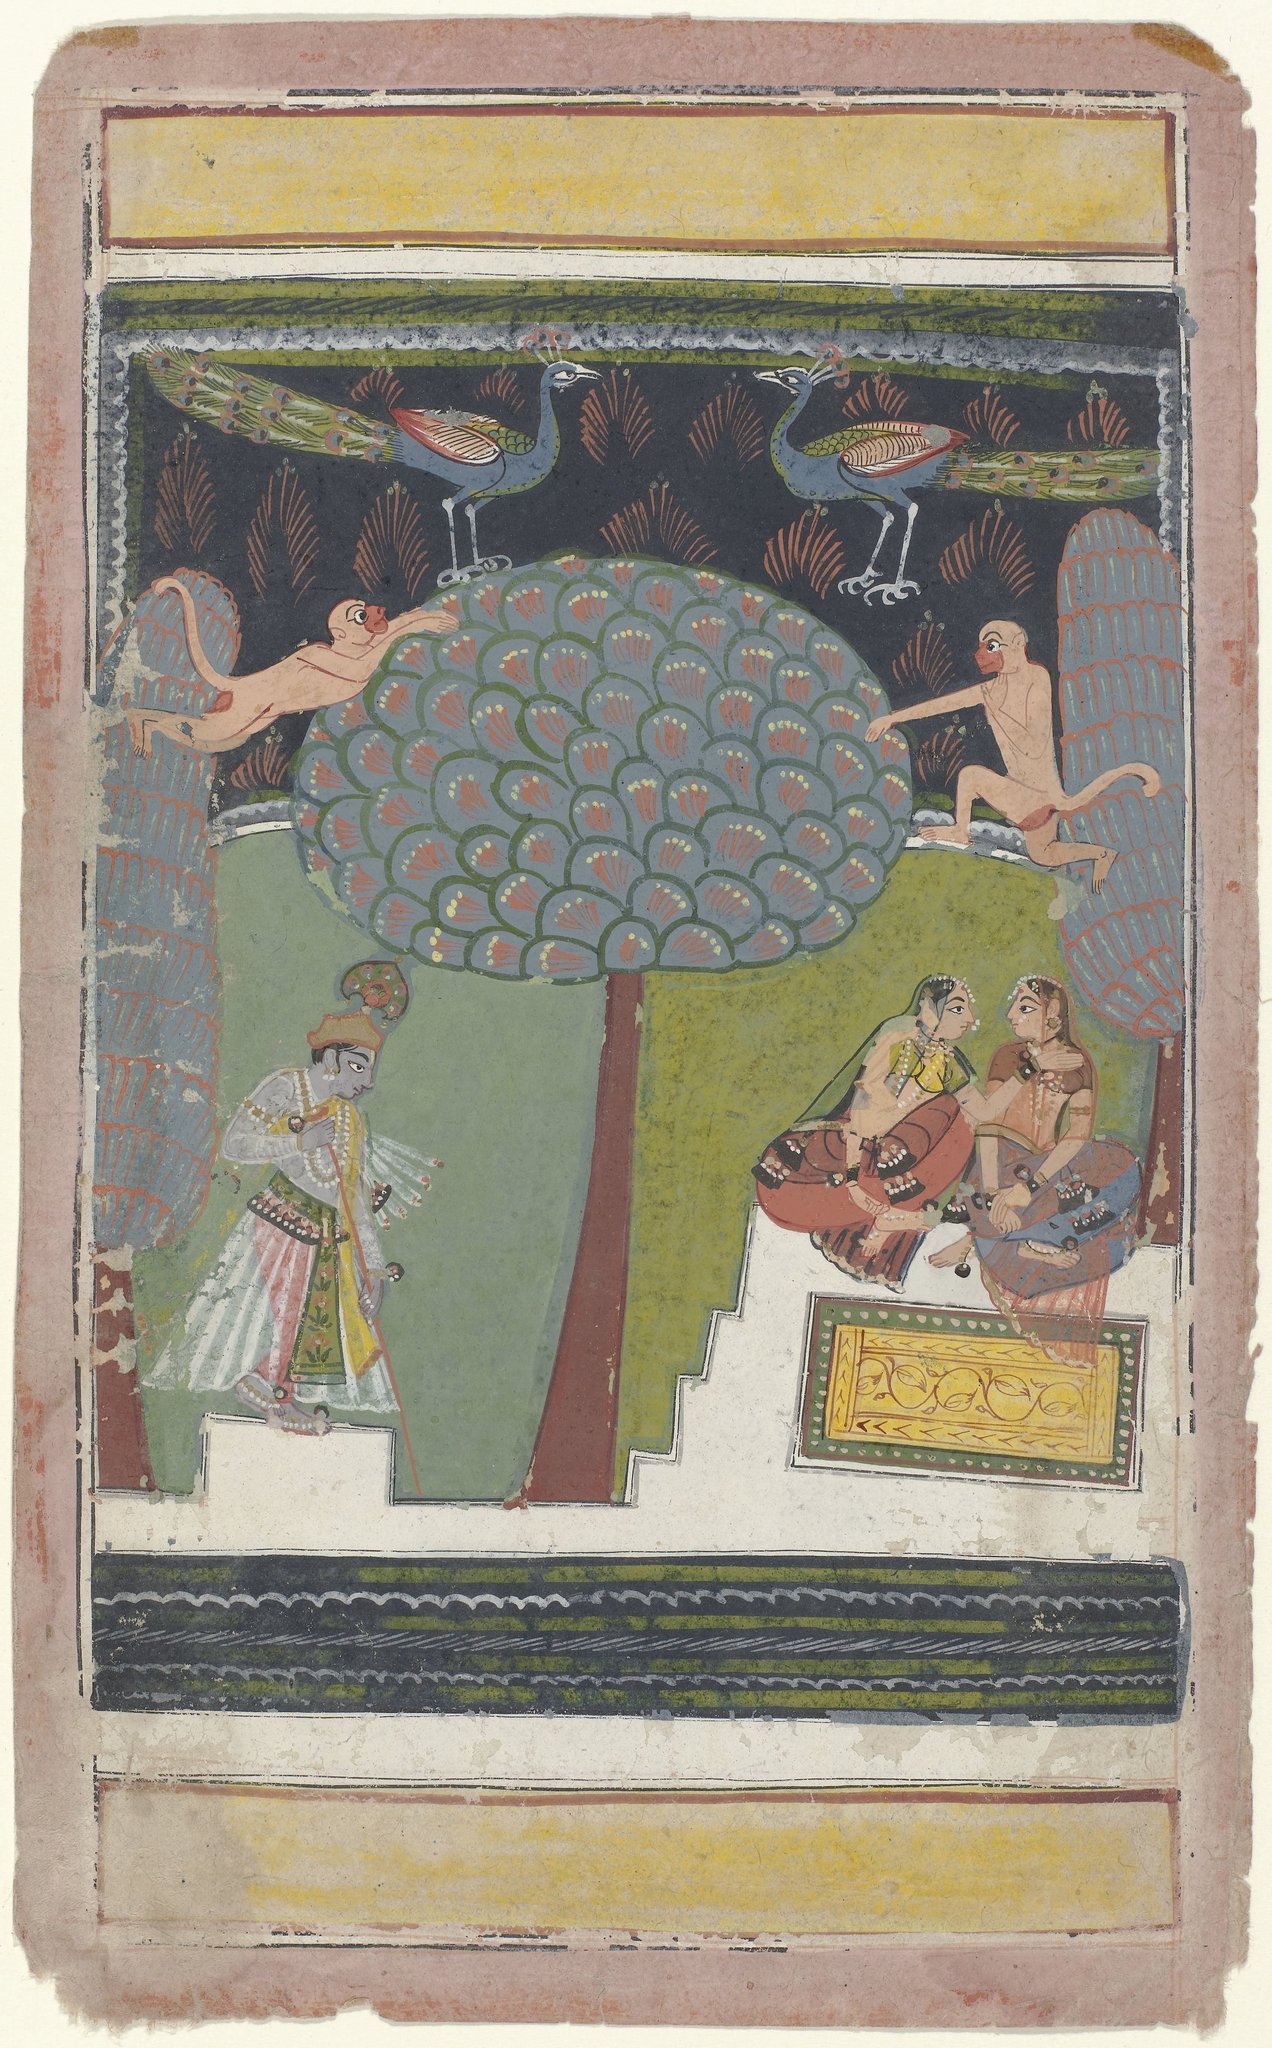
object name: indian miniature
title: Krishna and Two Women in a Garden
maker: Anonymous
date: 1620-1640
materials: paper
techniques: brush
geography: rajasthan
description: This miniature portrays an episode from the Rasikapriya, an anthology of love poetry. It sensuously illustrates the love that is both human and divine. According to the poem on the back, the women are talking about the youth and beauty of the newly married Radha, Krishna’s beloved lover. In the Rasikapriya, Radha and Krishna are seen as archetypal lovers.